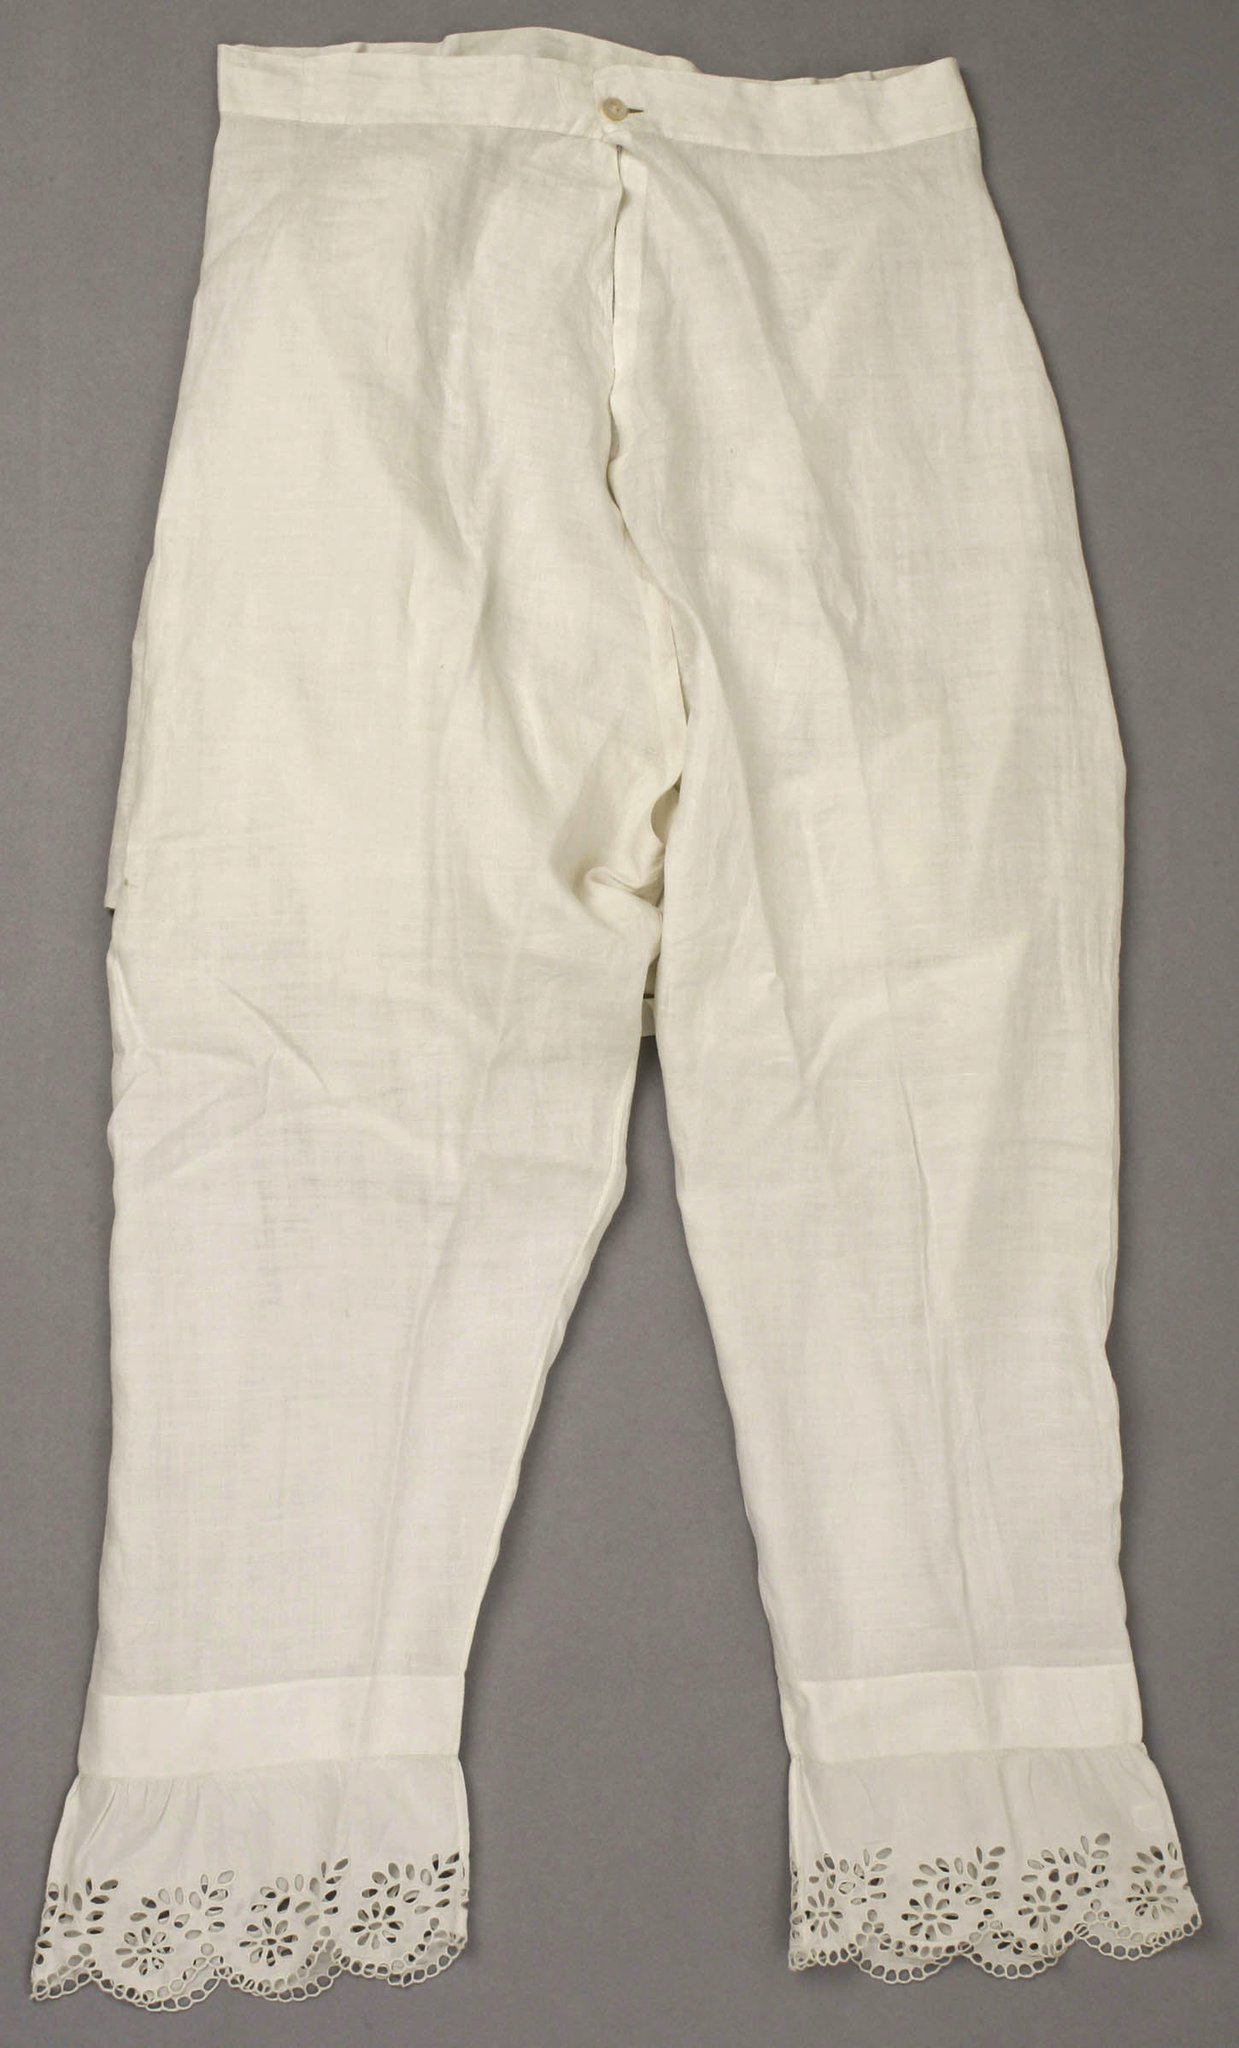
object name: pantalets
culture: american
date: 1830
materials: cotton, linen